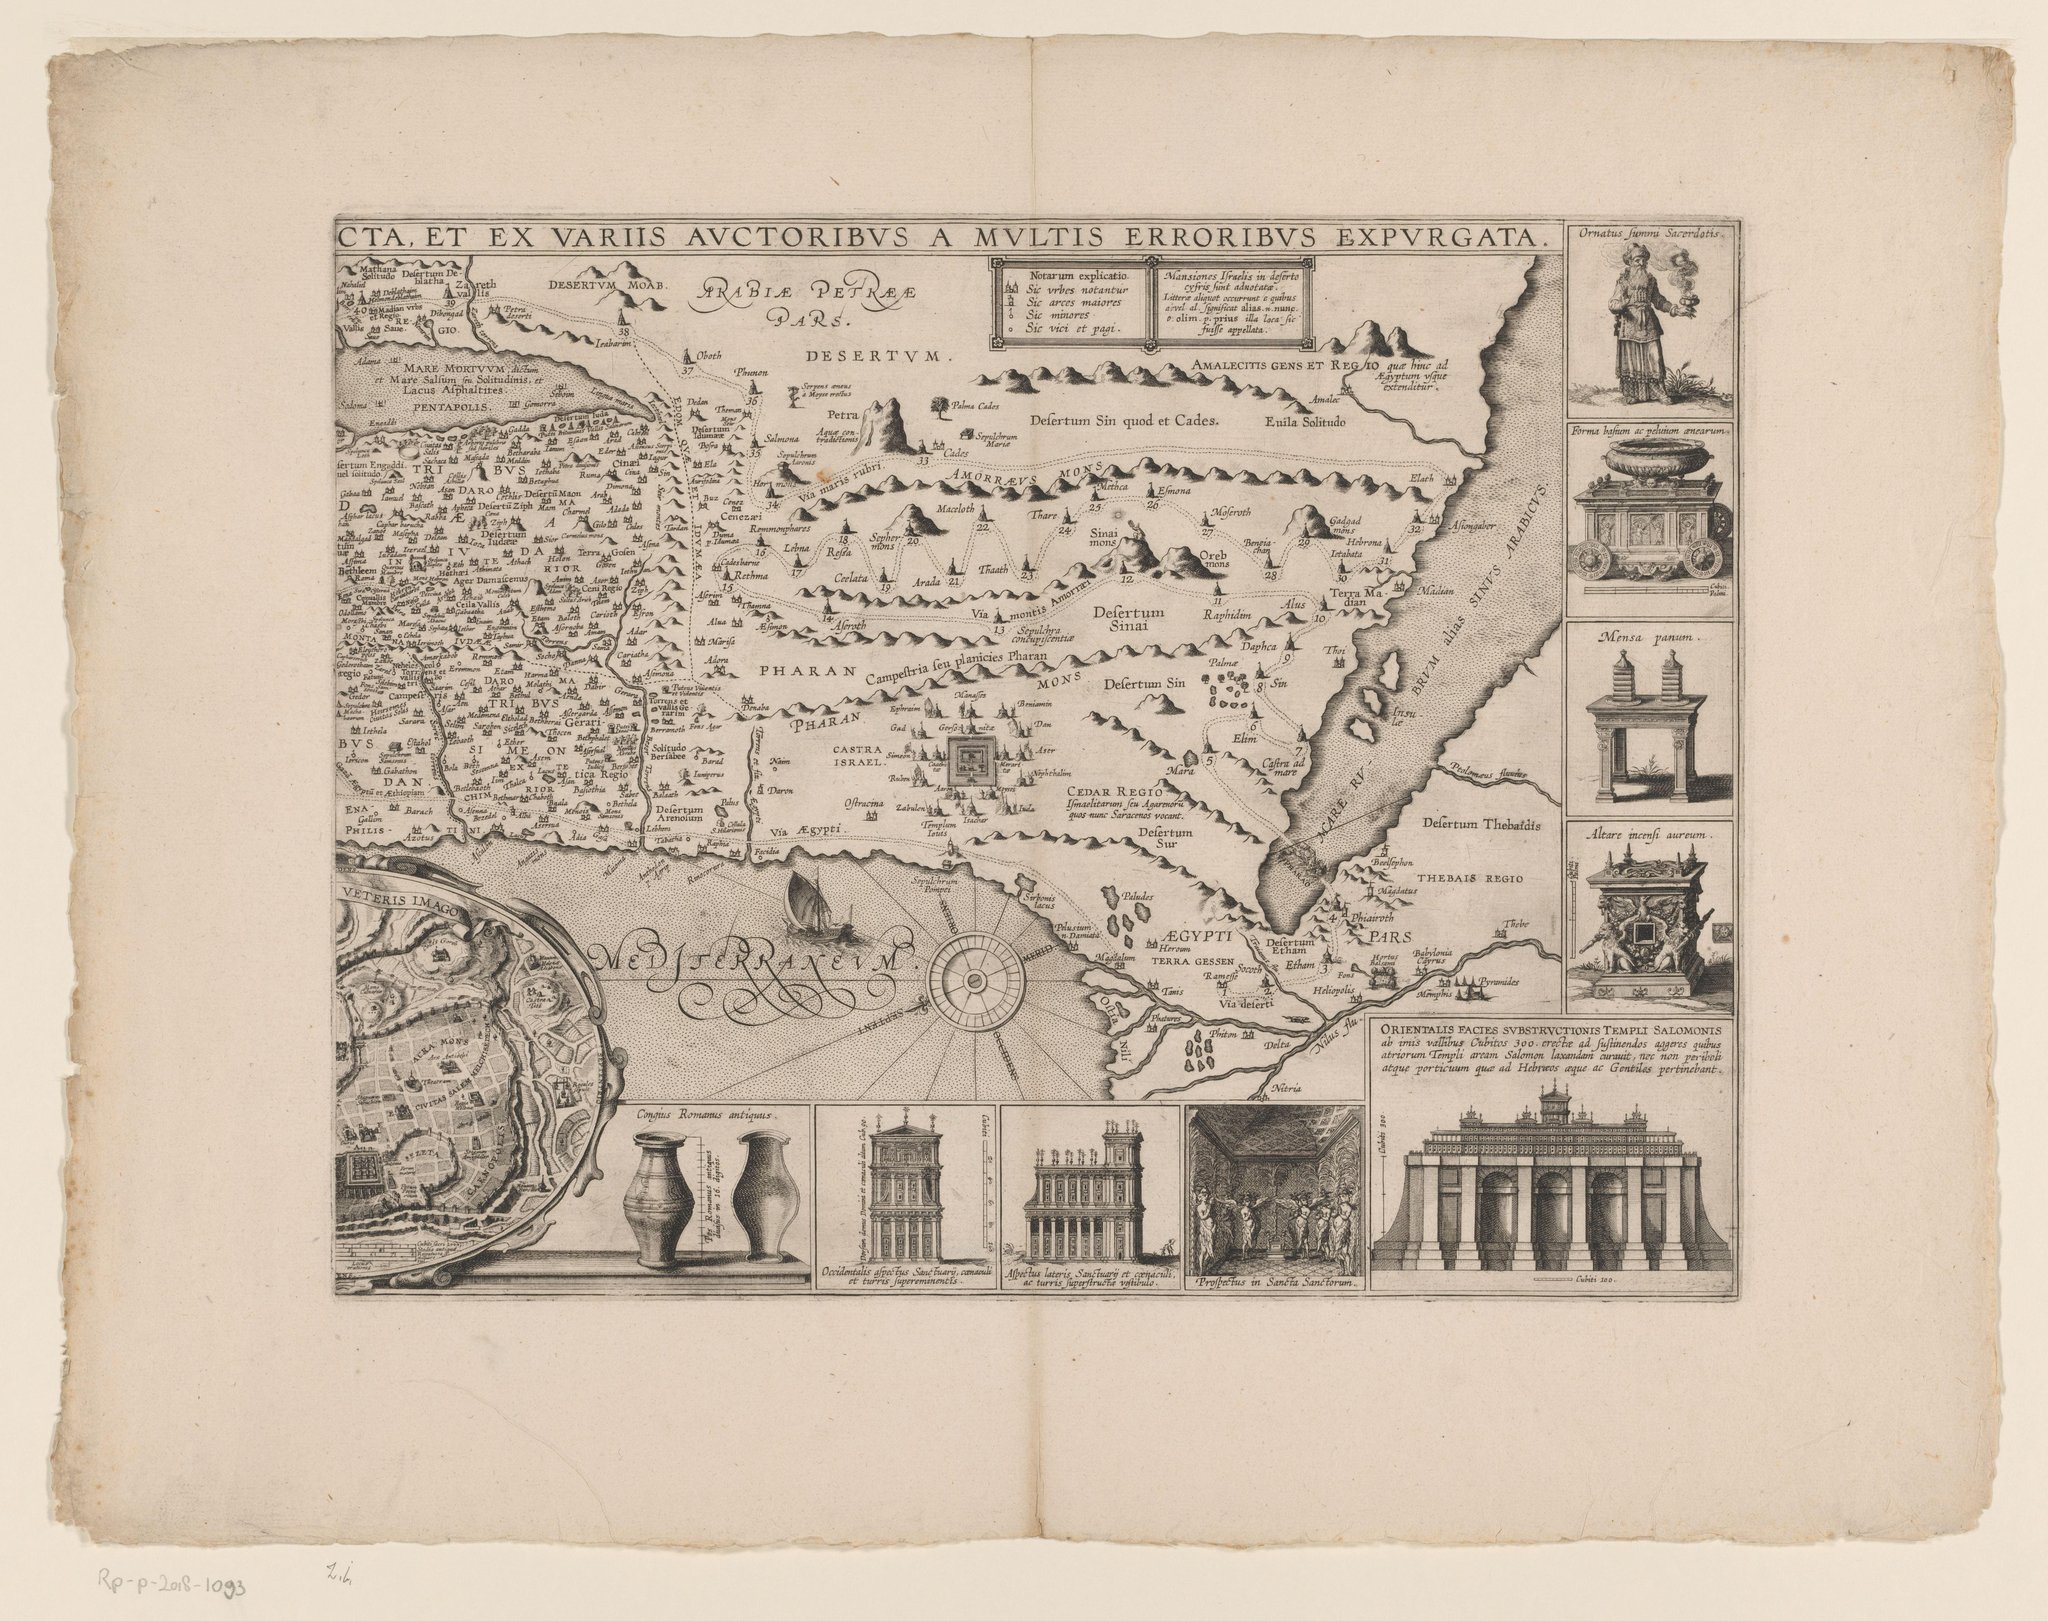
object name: print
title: Kaart van het Heilige Land, rechterdeel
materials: paper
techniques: engraving, etching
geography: antwerp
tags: maps of separate countries or regions, the book exodus: story of moses and aaron, maps of cities, the temple (in general) ~ jewish religion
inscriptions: collector's mark: Lugt 2228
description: Prent ook gebruikt in: Tirinus, Jacobus. Commentarius in Vetus et Novum Testamentum. Antwerpen: Martiuns Nutius (III), 1632.